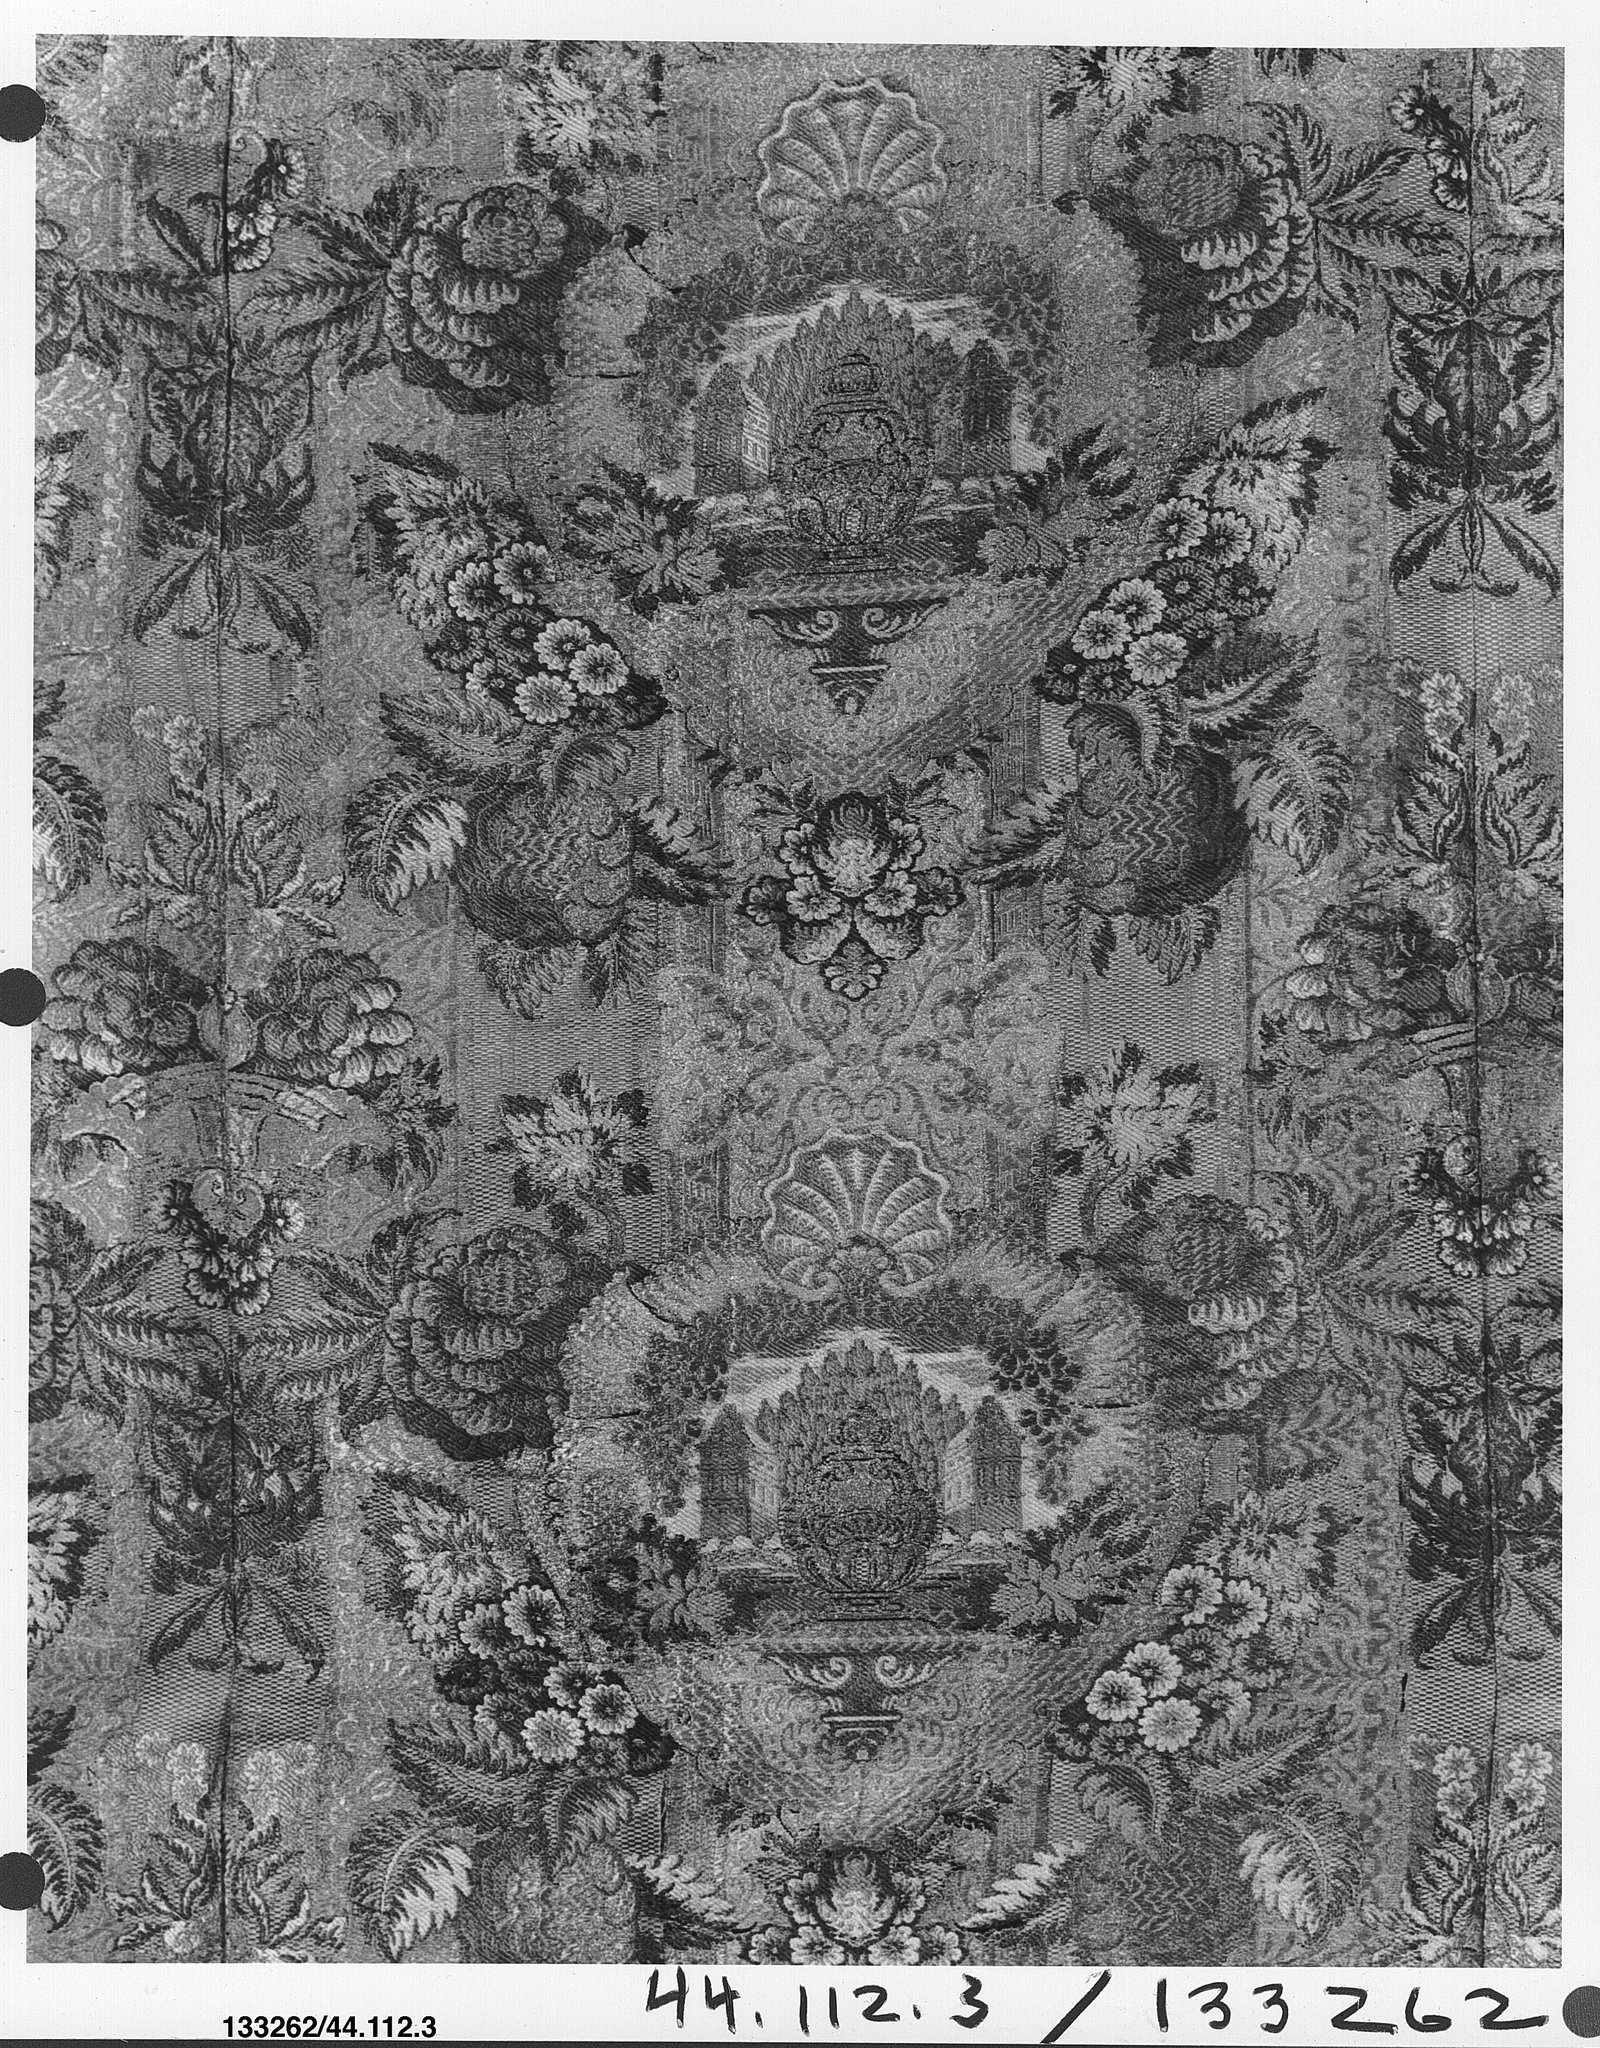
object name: piece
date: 1730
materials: metal thread, silk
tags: flowers,leaves